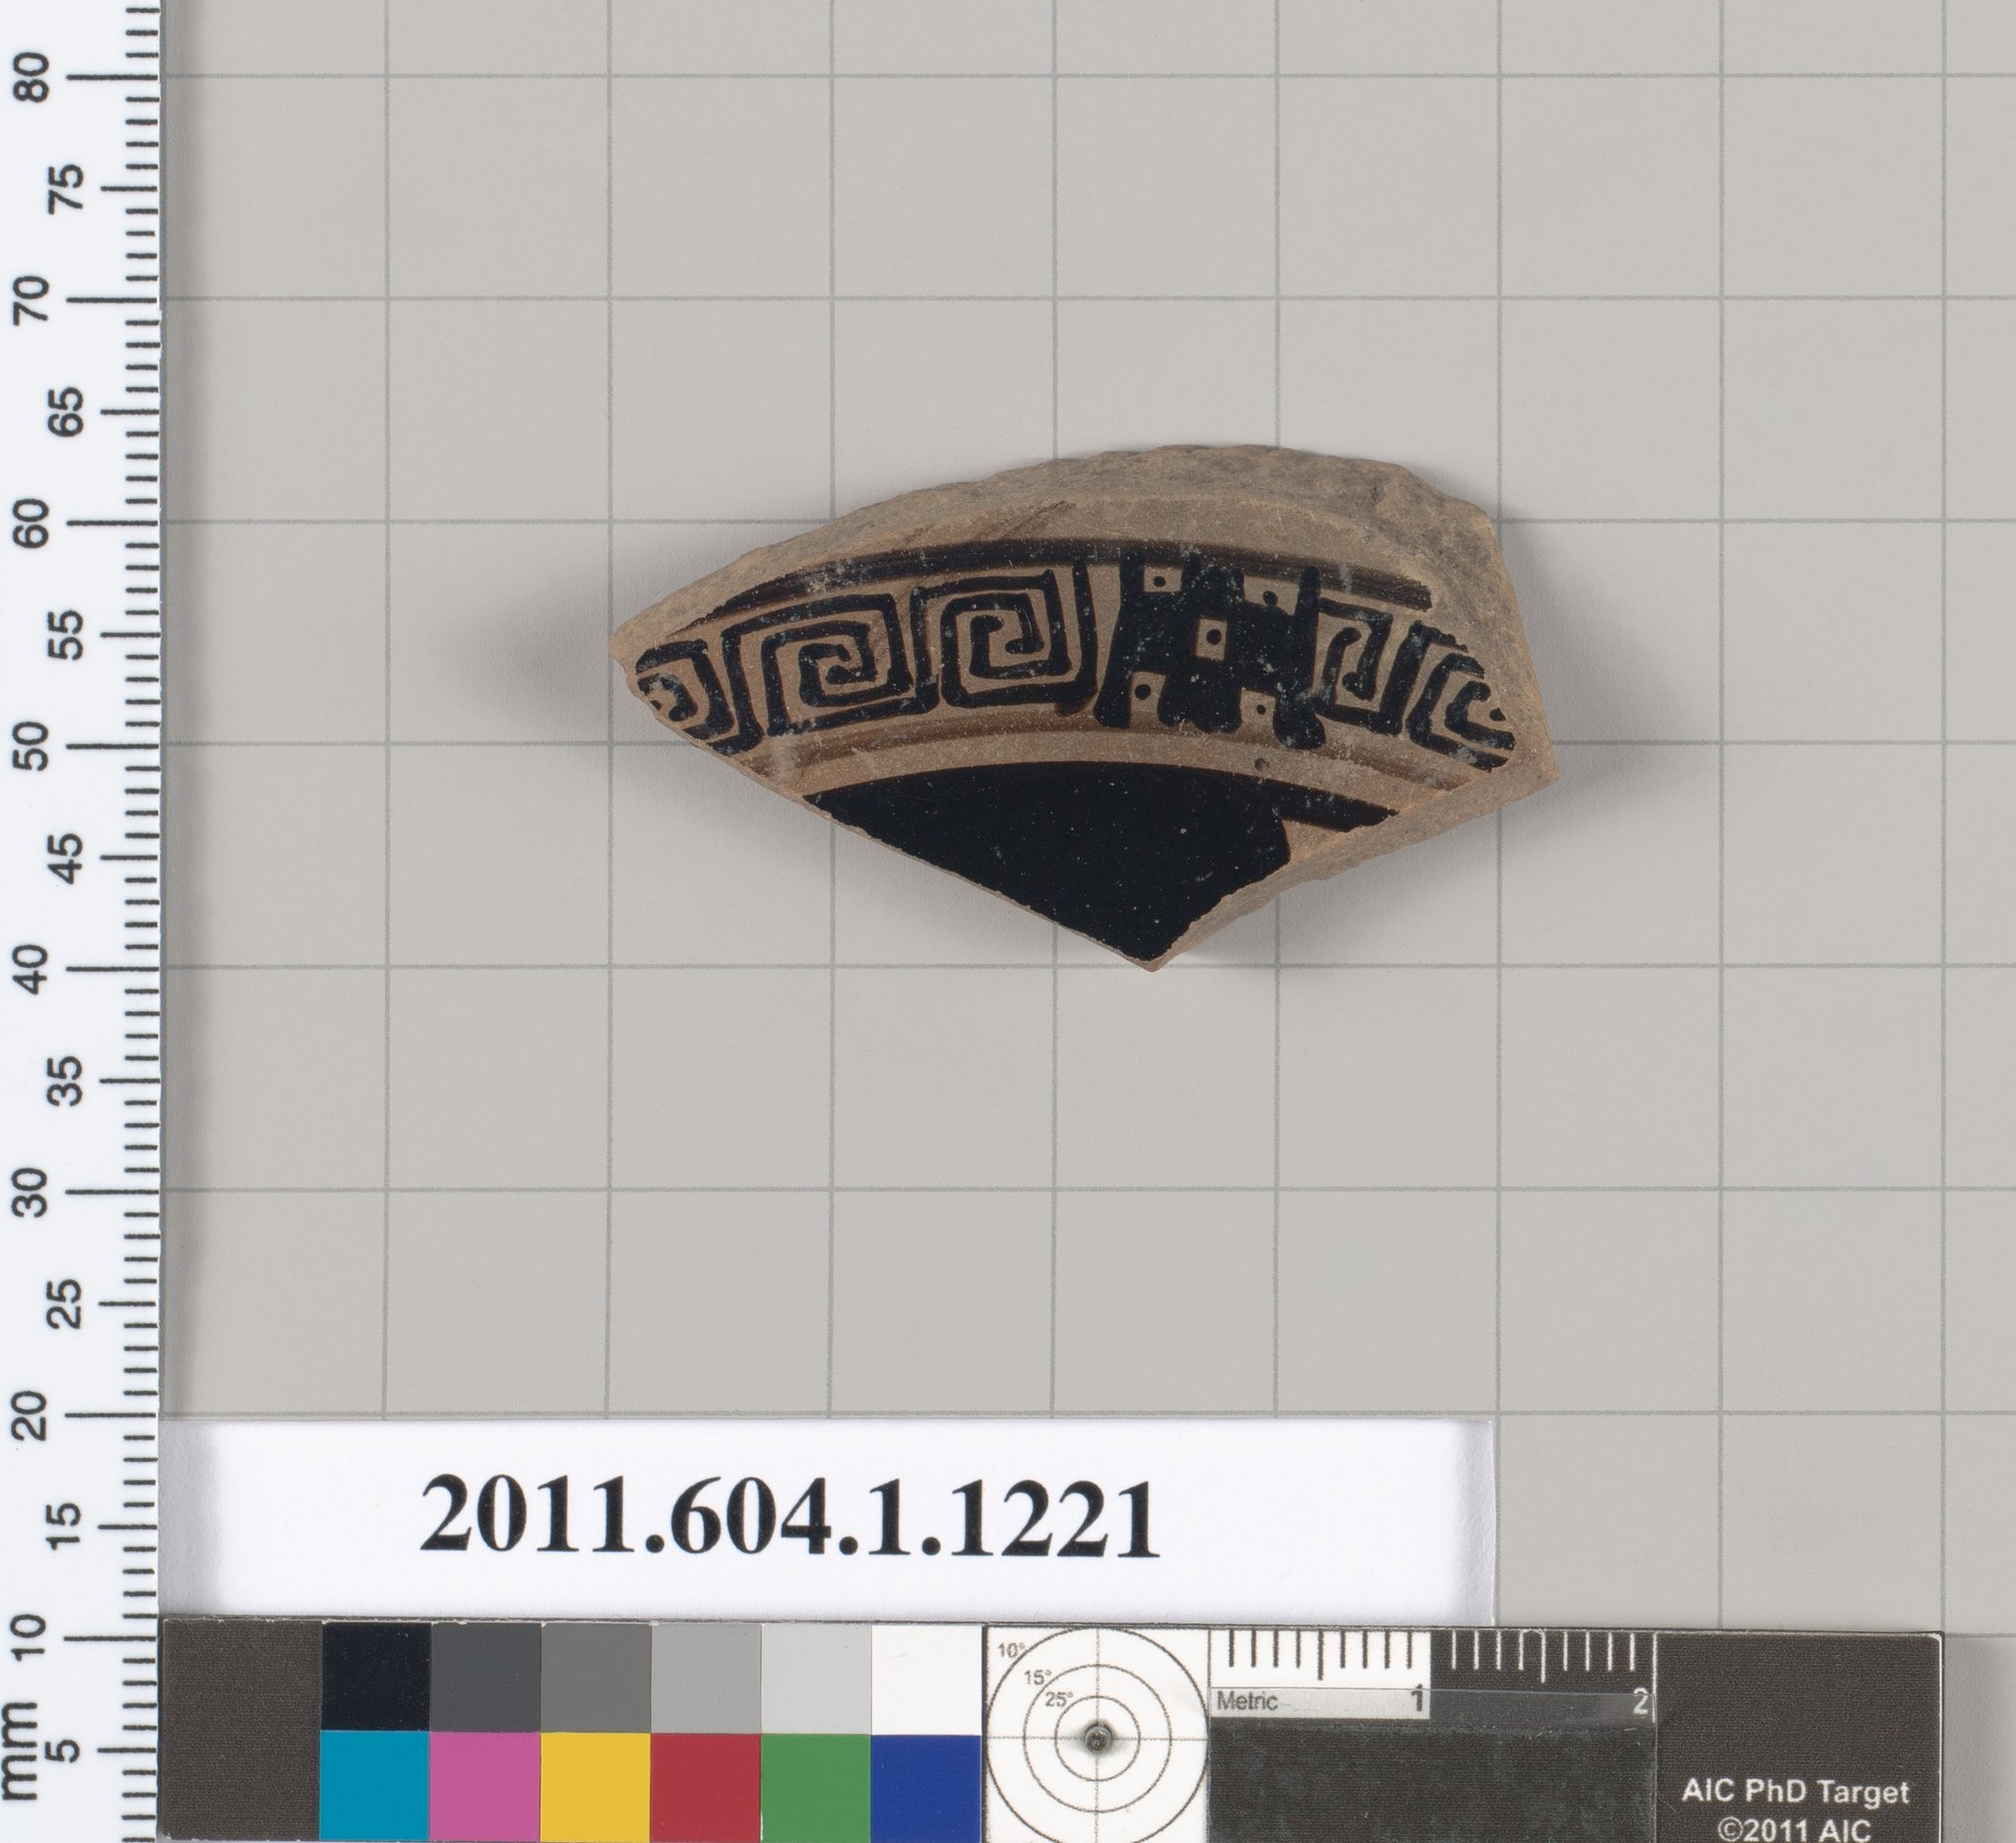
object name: kylix fragment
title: Terracotta fragment of a kylix (drinking cup)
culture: greek, attic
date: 490-480 BCE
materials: terracotta